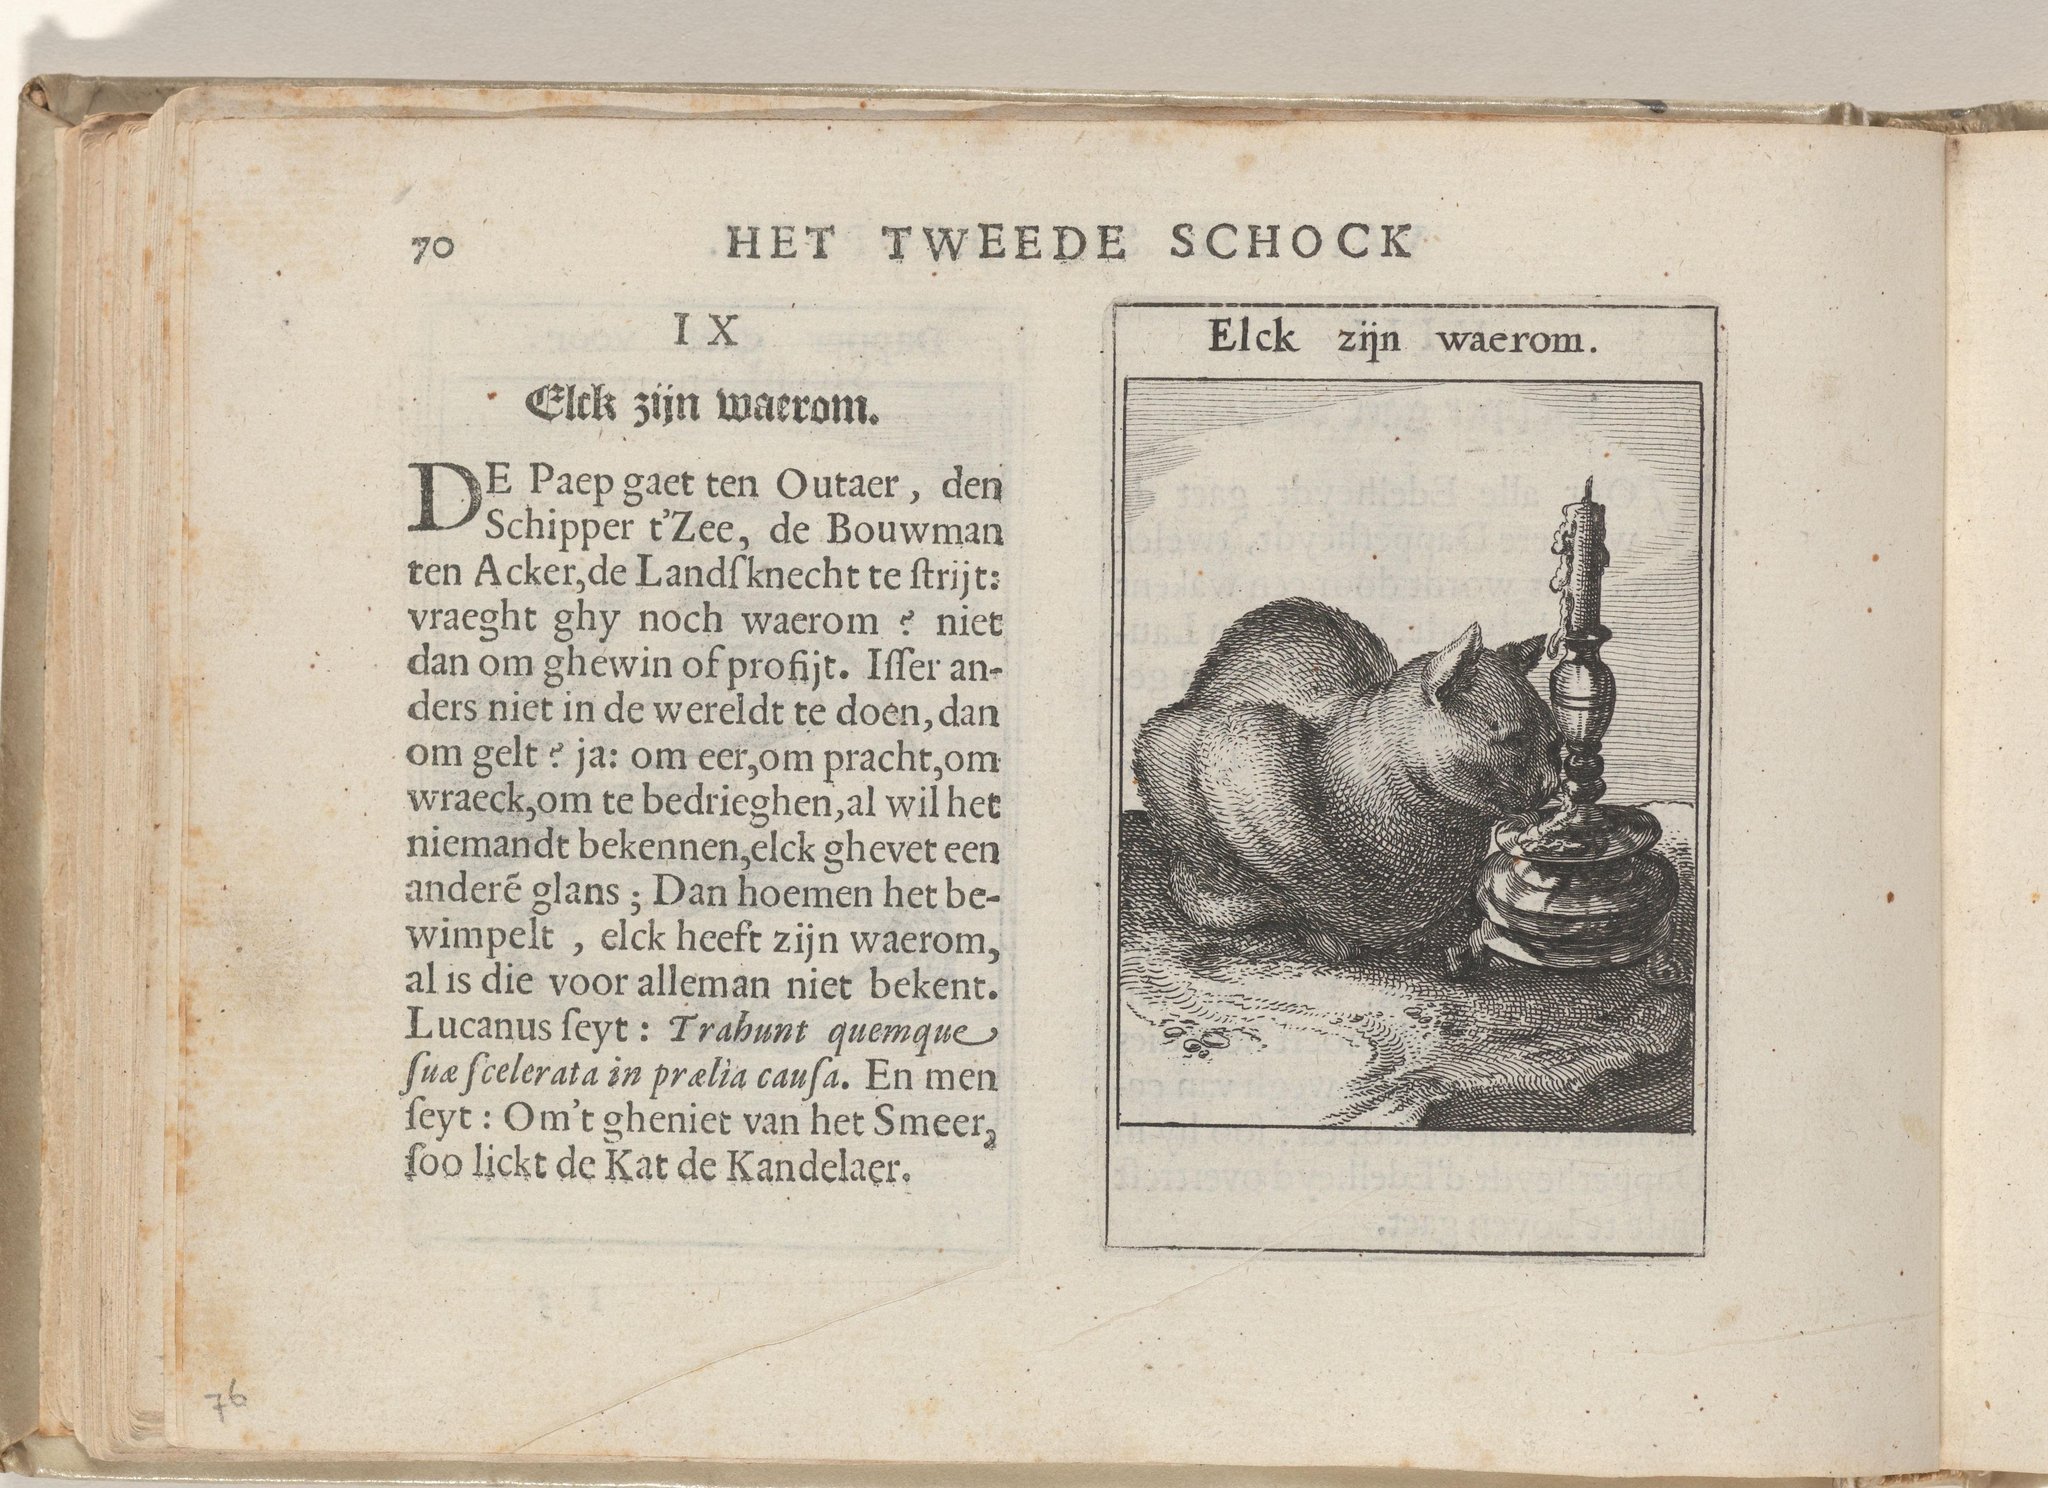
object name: print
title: IX Elck zijn waerom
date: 1614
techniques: engraving, printing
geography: amsterdam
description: IX Elck zijn waerom. Tweede schok. Onderdeel van 'Sinnepoppen', R. Visscher, 1614.